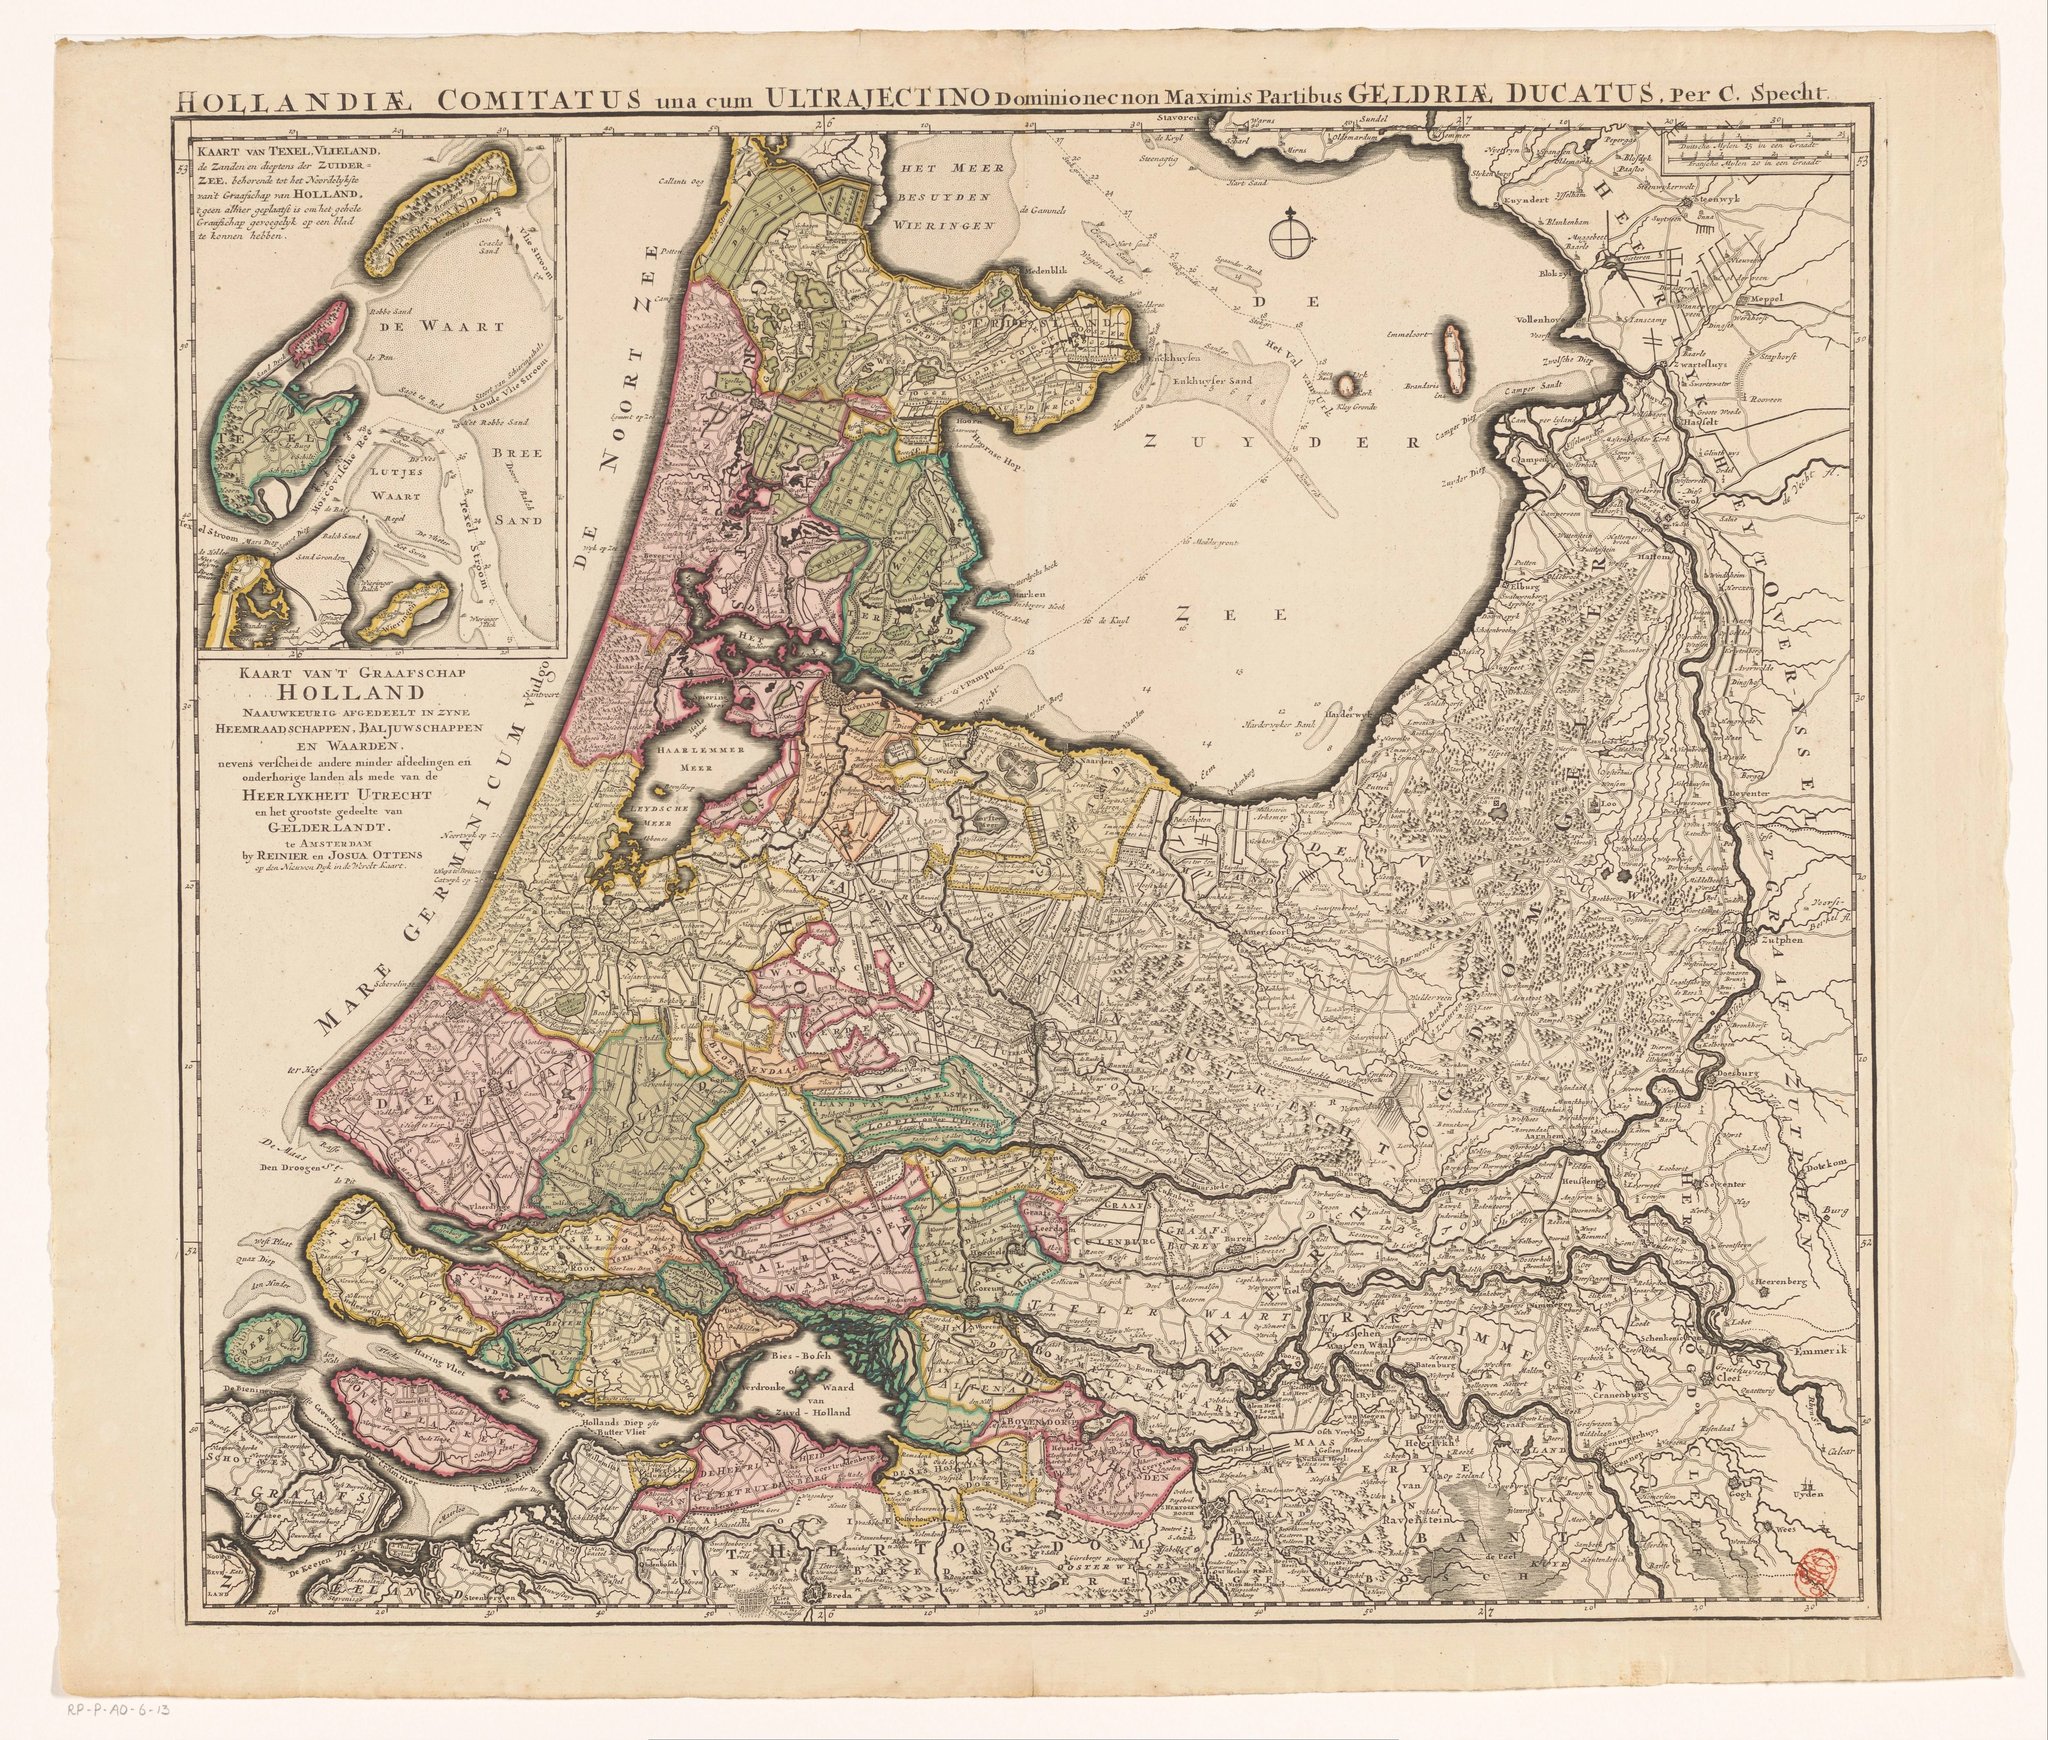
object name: map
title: Kaart van 't graafschap Holland naauwkeurig afgebeelt in zyne heemraadschappen, baljuwschappen en waarden (...) / Hollandiae comitatus una cum Ultrajectino dominio nec non maximis partibus Geldriae ducatus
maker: caspar specht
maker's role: print maker, publisher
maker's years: 1654-1710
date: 1704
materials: paper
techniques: engraving, hand coloring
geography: utrecht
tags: maps of separate countries or regions, gelderland, holland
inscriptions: collector's mark: Lugt 195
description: Kaart van het graafschap Holland, de heerlijkheid Utrecht en het grootste deel van het hertogdom Gelderland. Linksboven een inzetkaart van Texel en Vlieland. Daaronder de Nederlandse titel. Rechtsboven twee schaalstokken: Duitsche mylen 15 in een graadt; Fransche mylen 20 in een graadt. Gradenverdeling langs de randen.